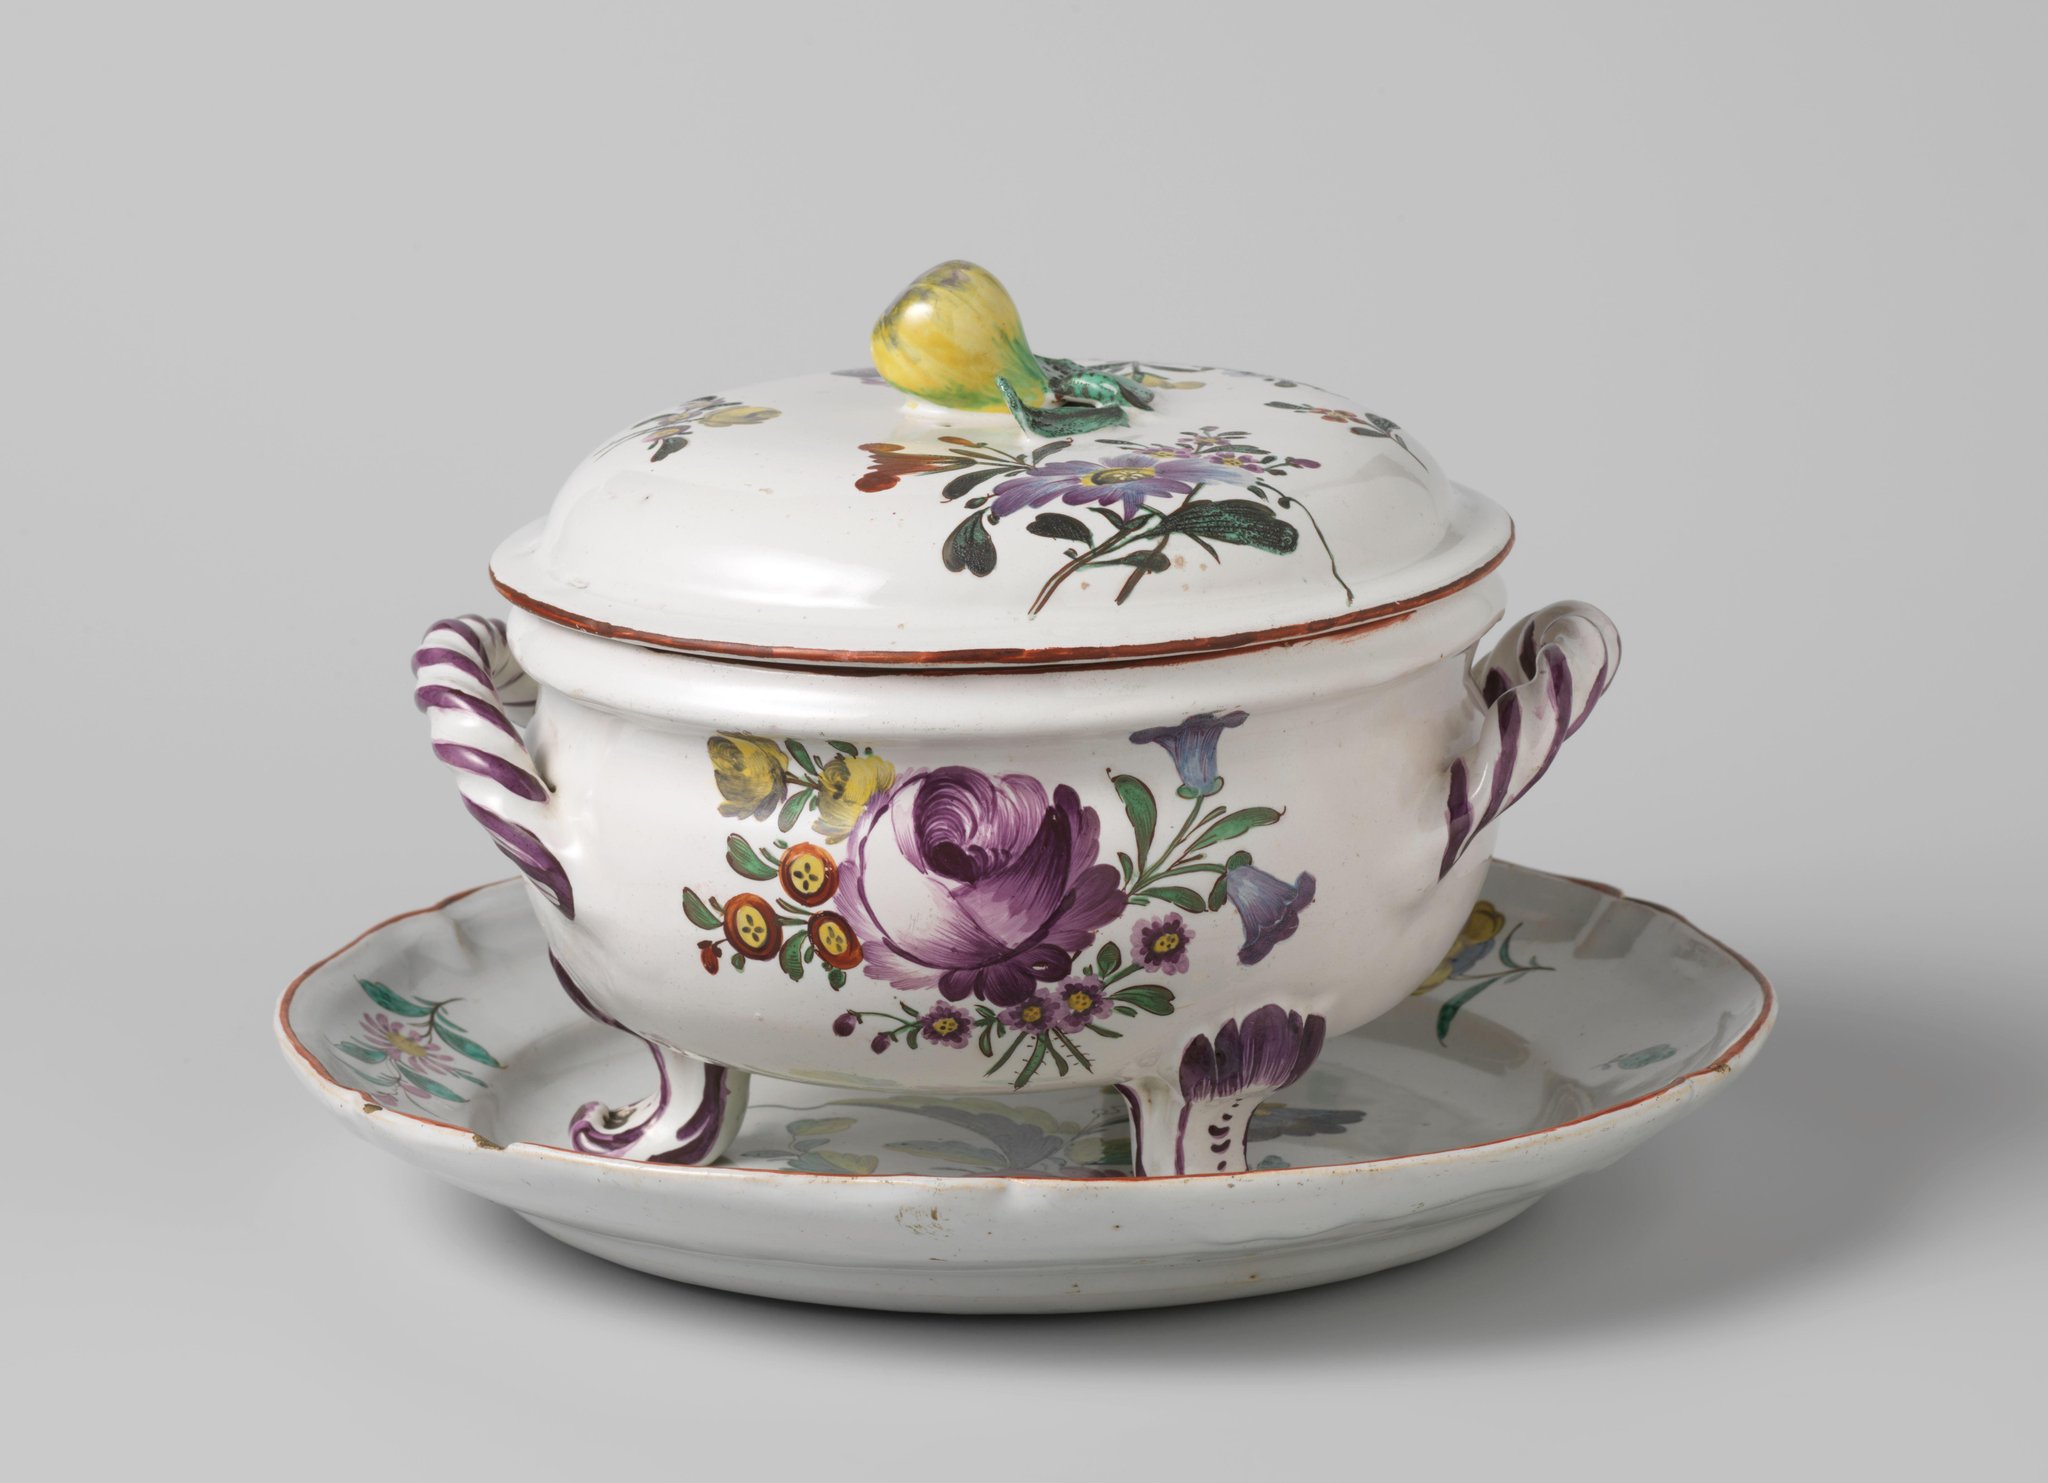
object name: tureen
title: Terrine op schotel, veelkleurig beschilderd met een bloemboeket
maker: johan van kerkhoff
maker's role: fayencier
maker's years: 1716-1773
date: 1760-1770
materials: faience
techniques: kiln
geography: arnhem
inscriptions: mark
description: Tureen with lid and stand. Faience with grand feu decoration. Arnhem, c. 1760 - 1770. Factory of Johan van Kerckhoff